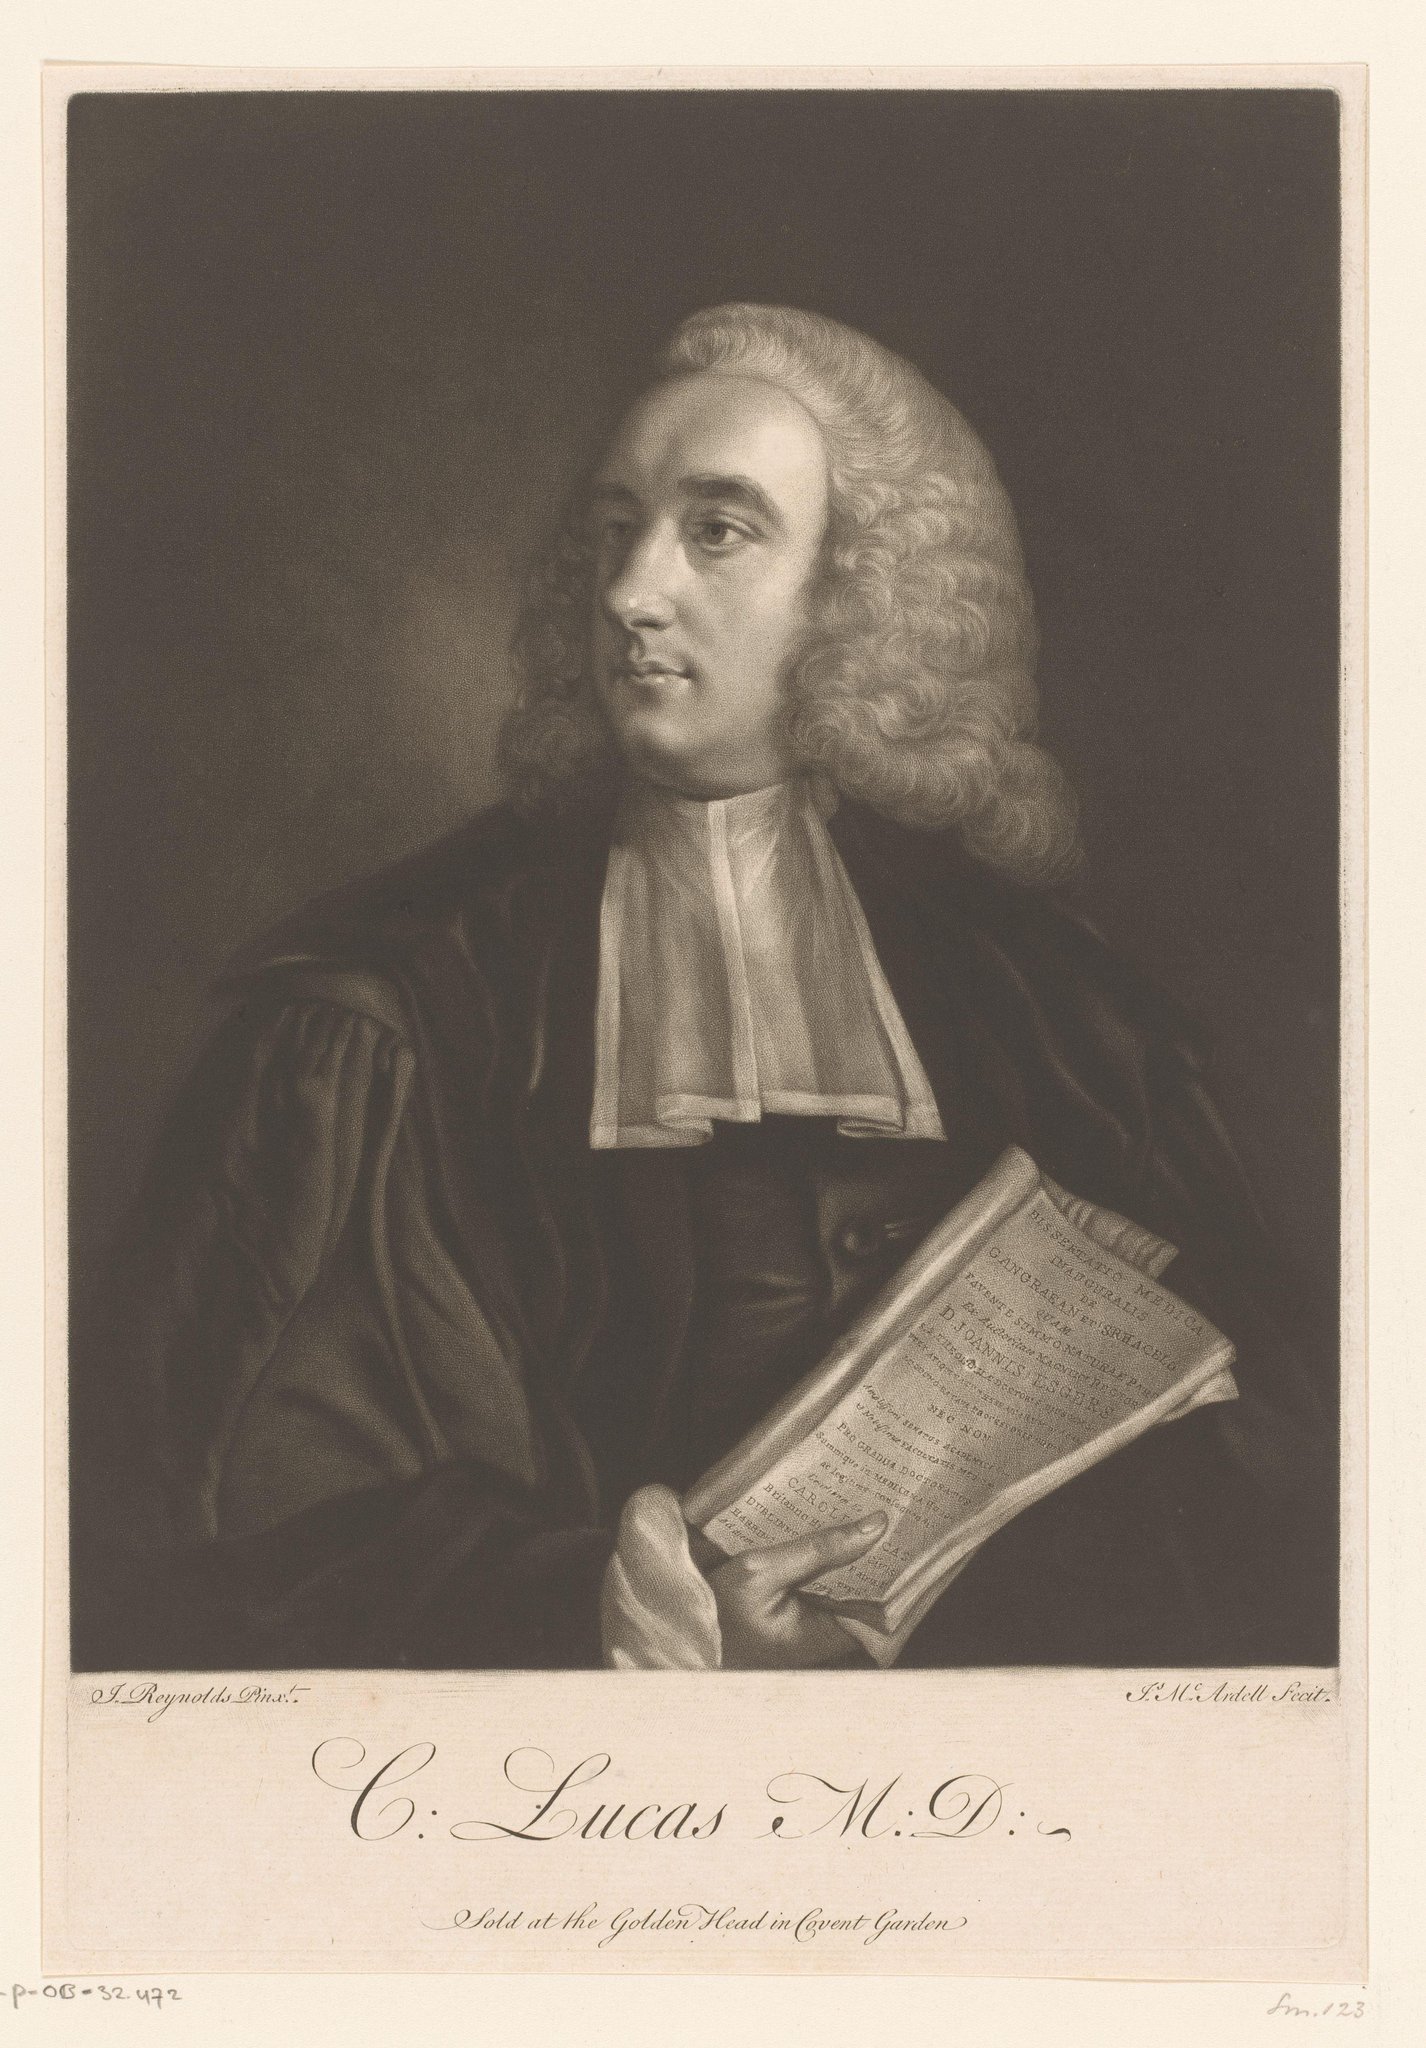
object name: print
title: Portret van Charles Lucas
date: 1755-1765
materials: paper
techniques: mezzotint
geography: london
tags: politician, historical persons, physician, doctor (+ portrait of scholar, scientist)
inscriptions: collector's mark: Lugt 240